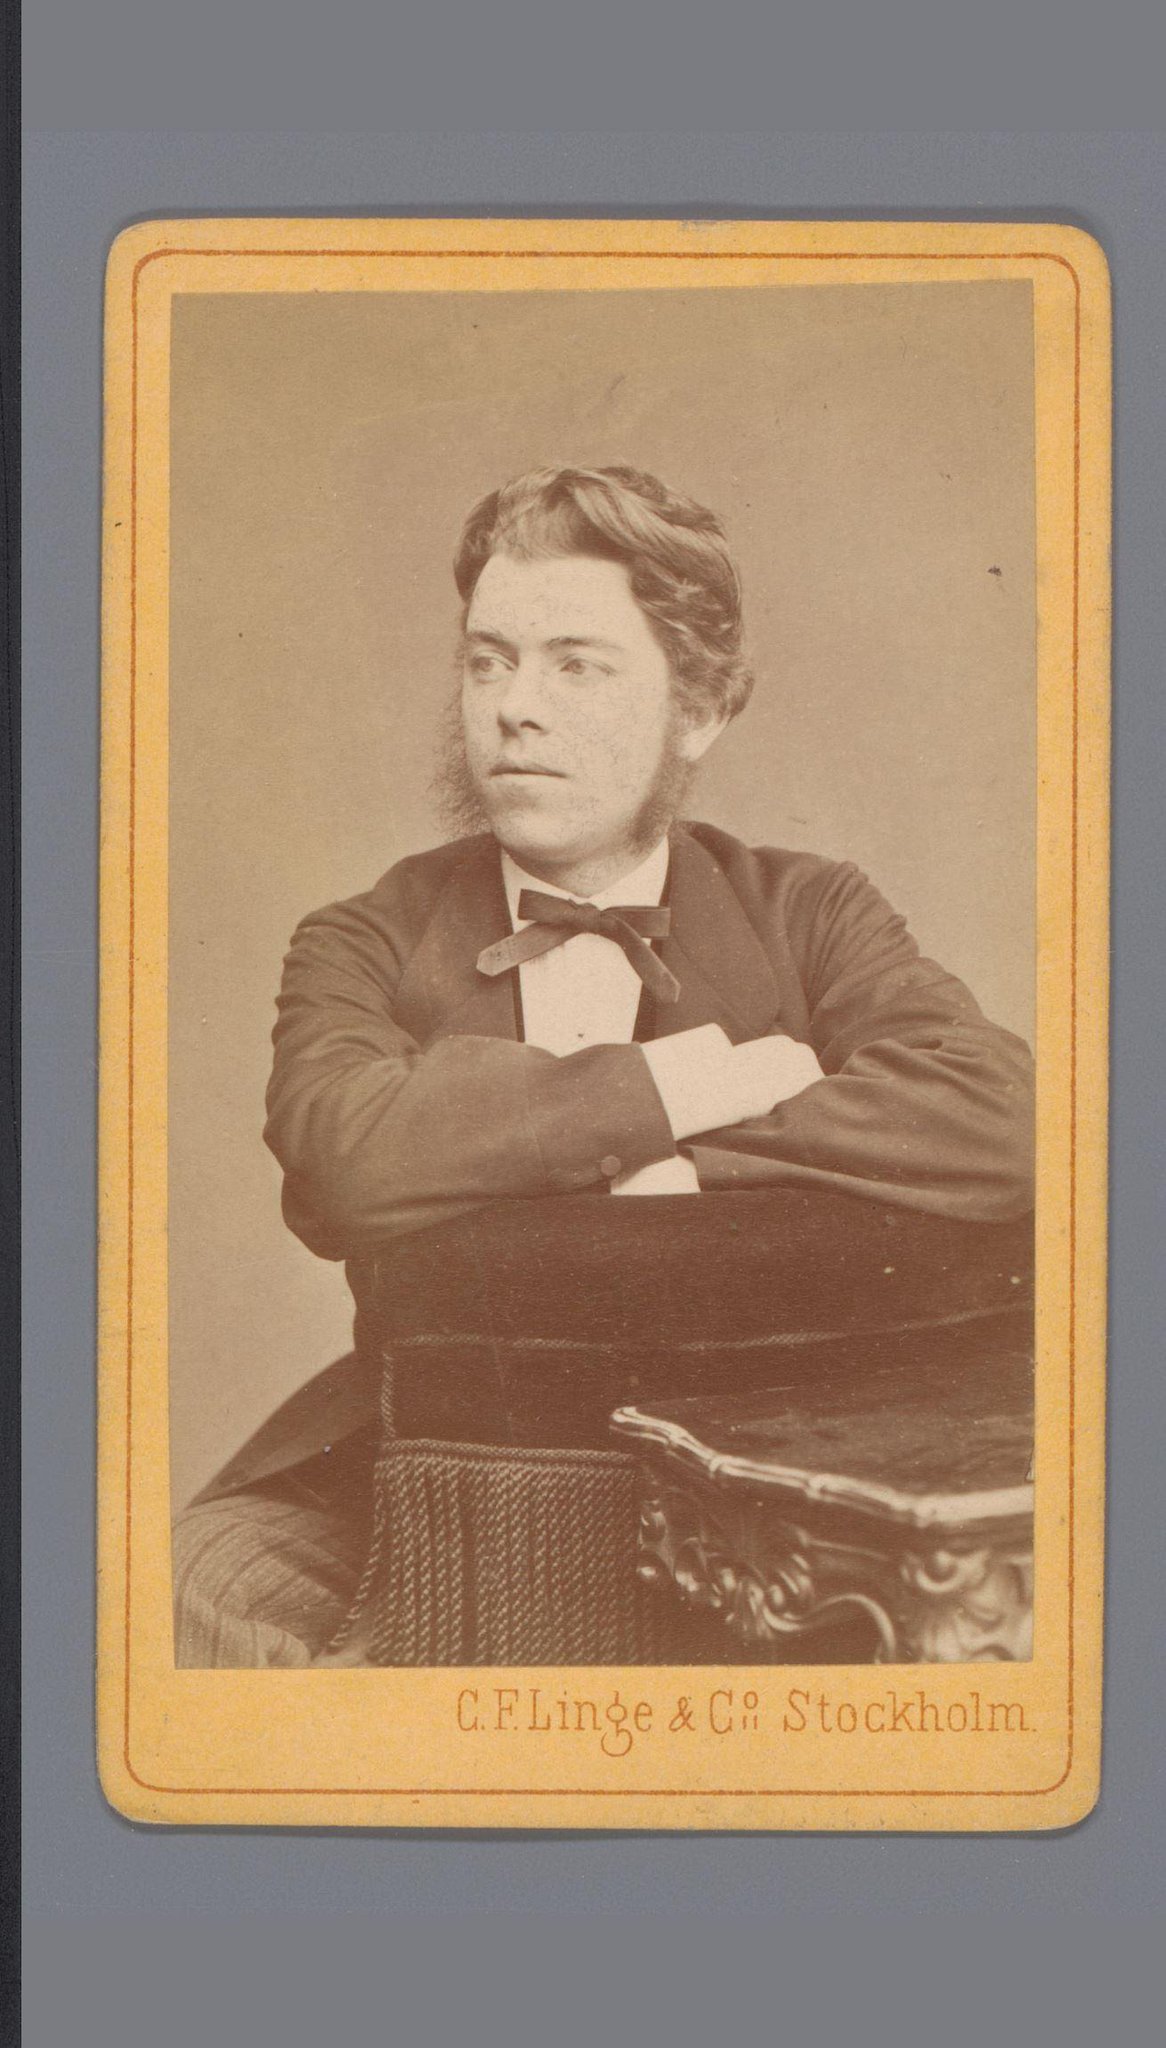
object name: photograph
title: Portret van een onbekende man achterstevoren gezeten op een stoel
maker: linge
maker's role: fotograaf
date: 1864-1891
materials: cardboard, paper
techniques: albumen print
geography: stockholm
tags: sitting figure, adult man, historical persons, chair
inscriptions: inscription: ‘C. F. LINGE & Co./ (...)/ STOCKHOLM/ Stora Badstugatan No. 3./ Å SÖDER/ Andra Huset till venster,/ från Södermalmstorg.’, inscription: ‘[...] Kjellin’, inscription: ‘025’